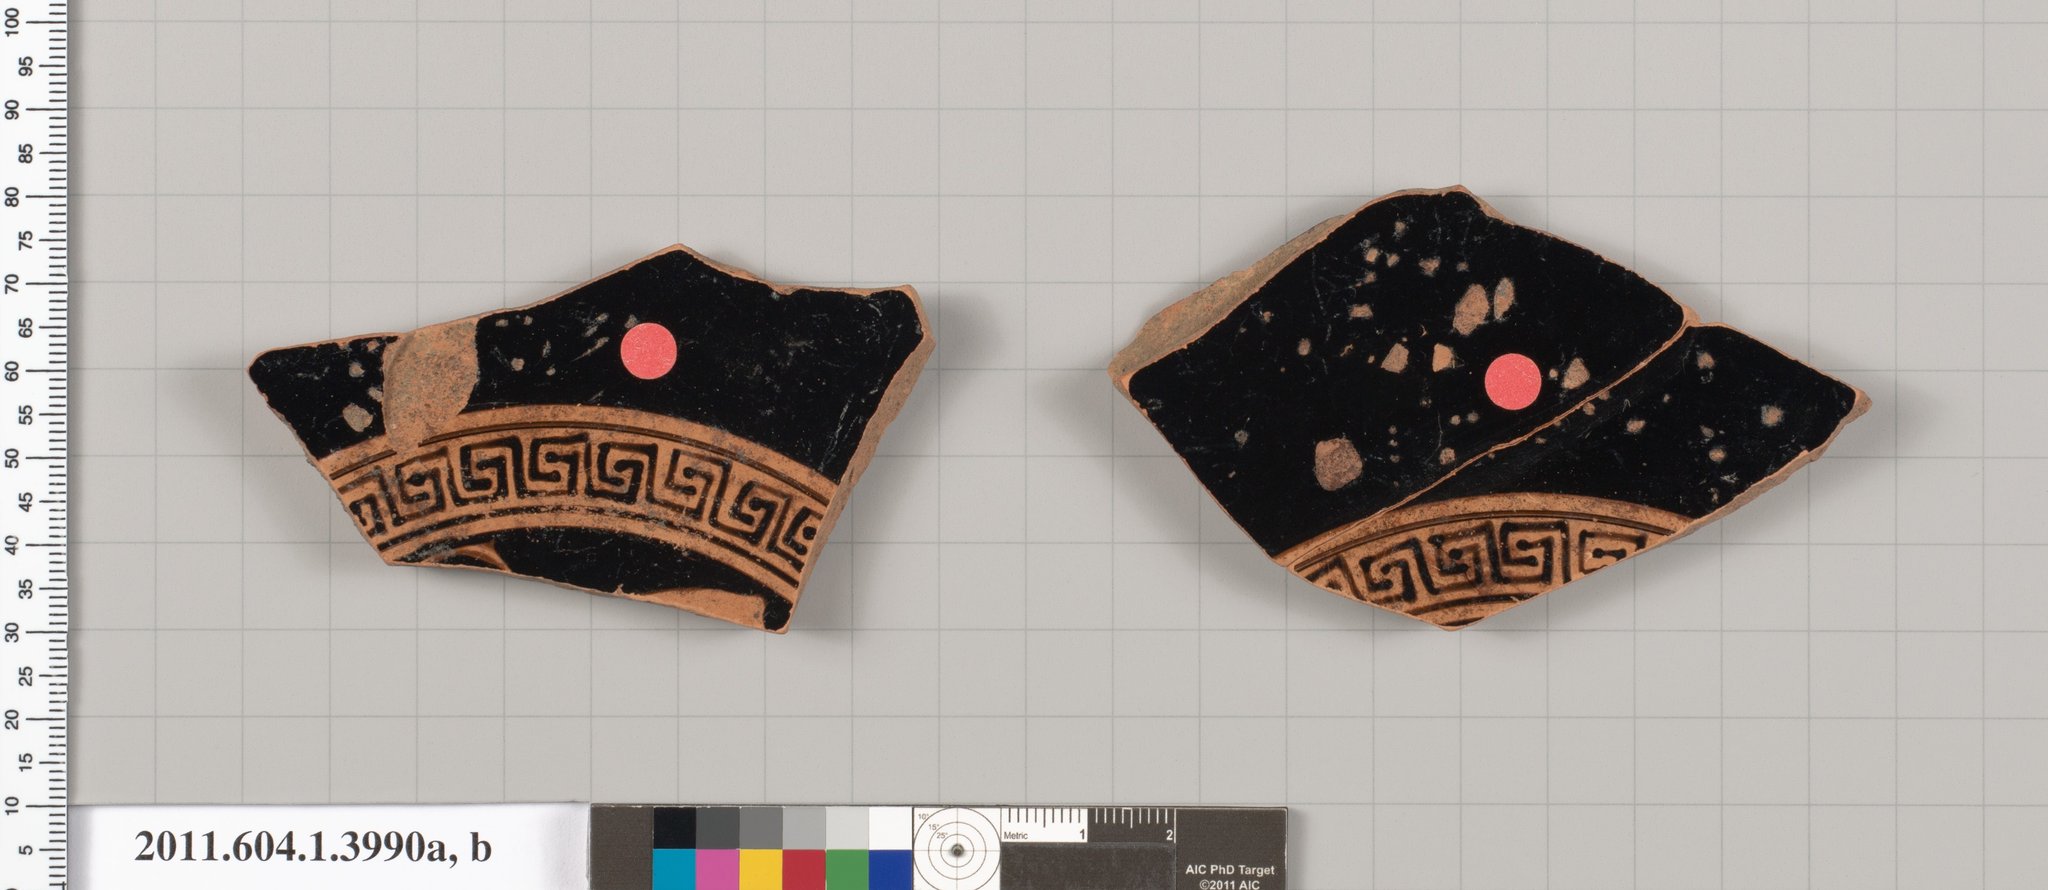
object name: kylix fragment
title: Terracotta fragments of a kylix (drinking cup)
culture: greek, attic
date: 475-451 BCE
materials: terracotta